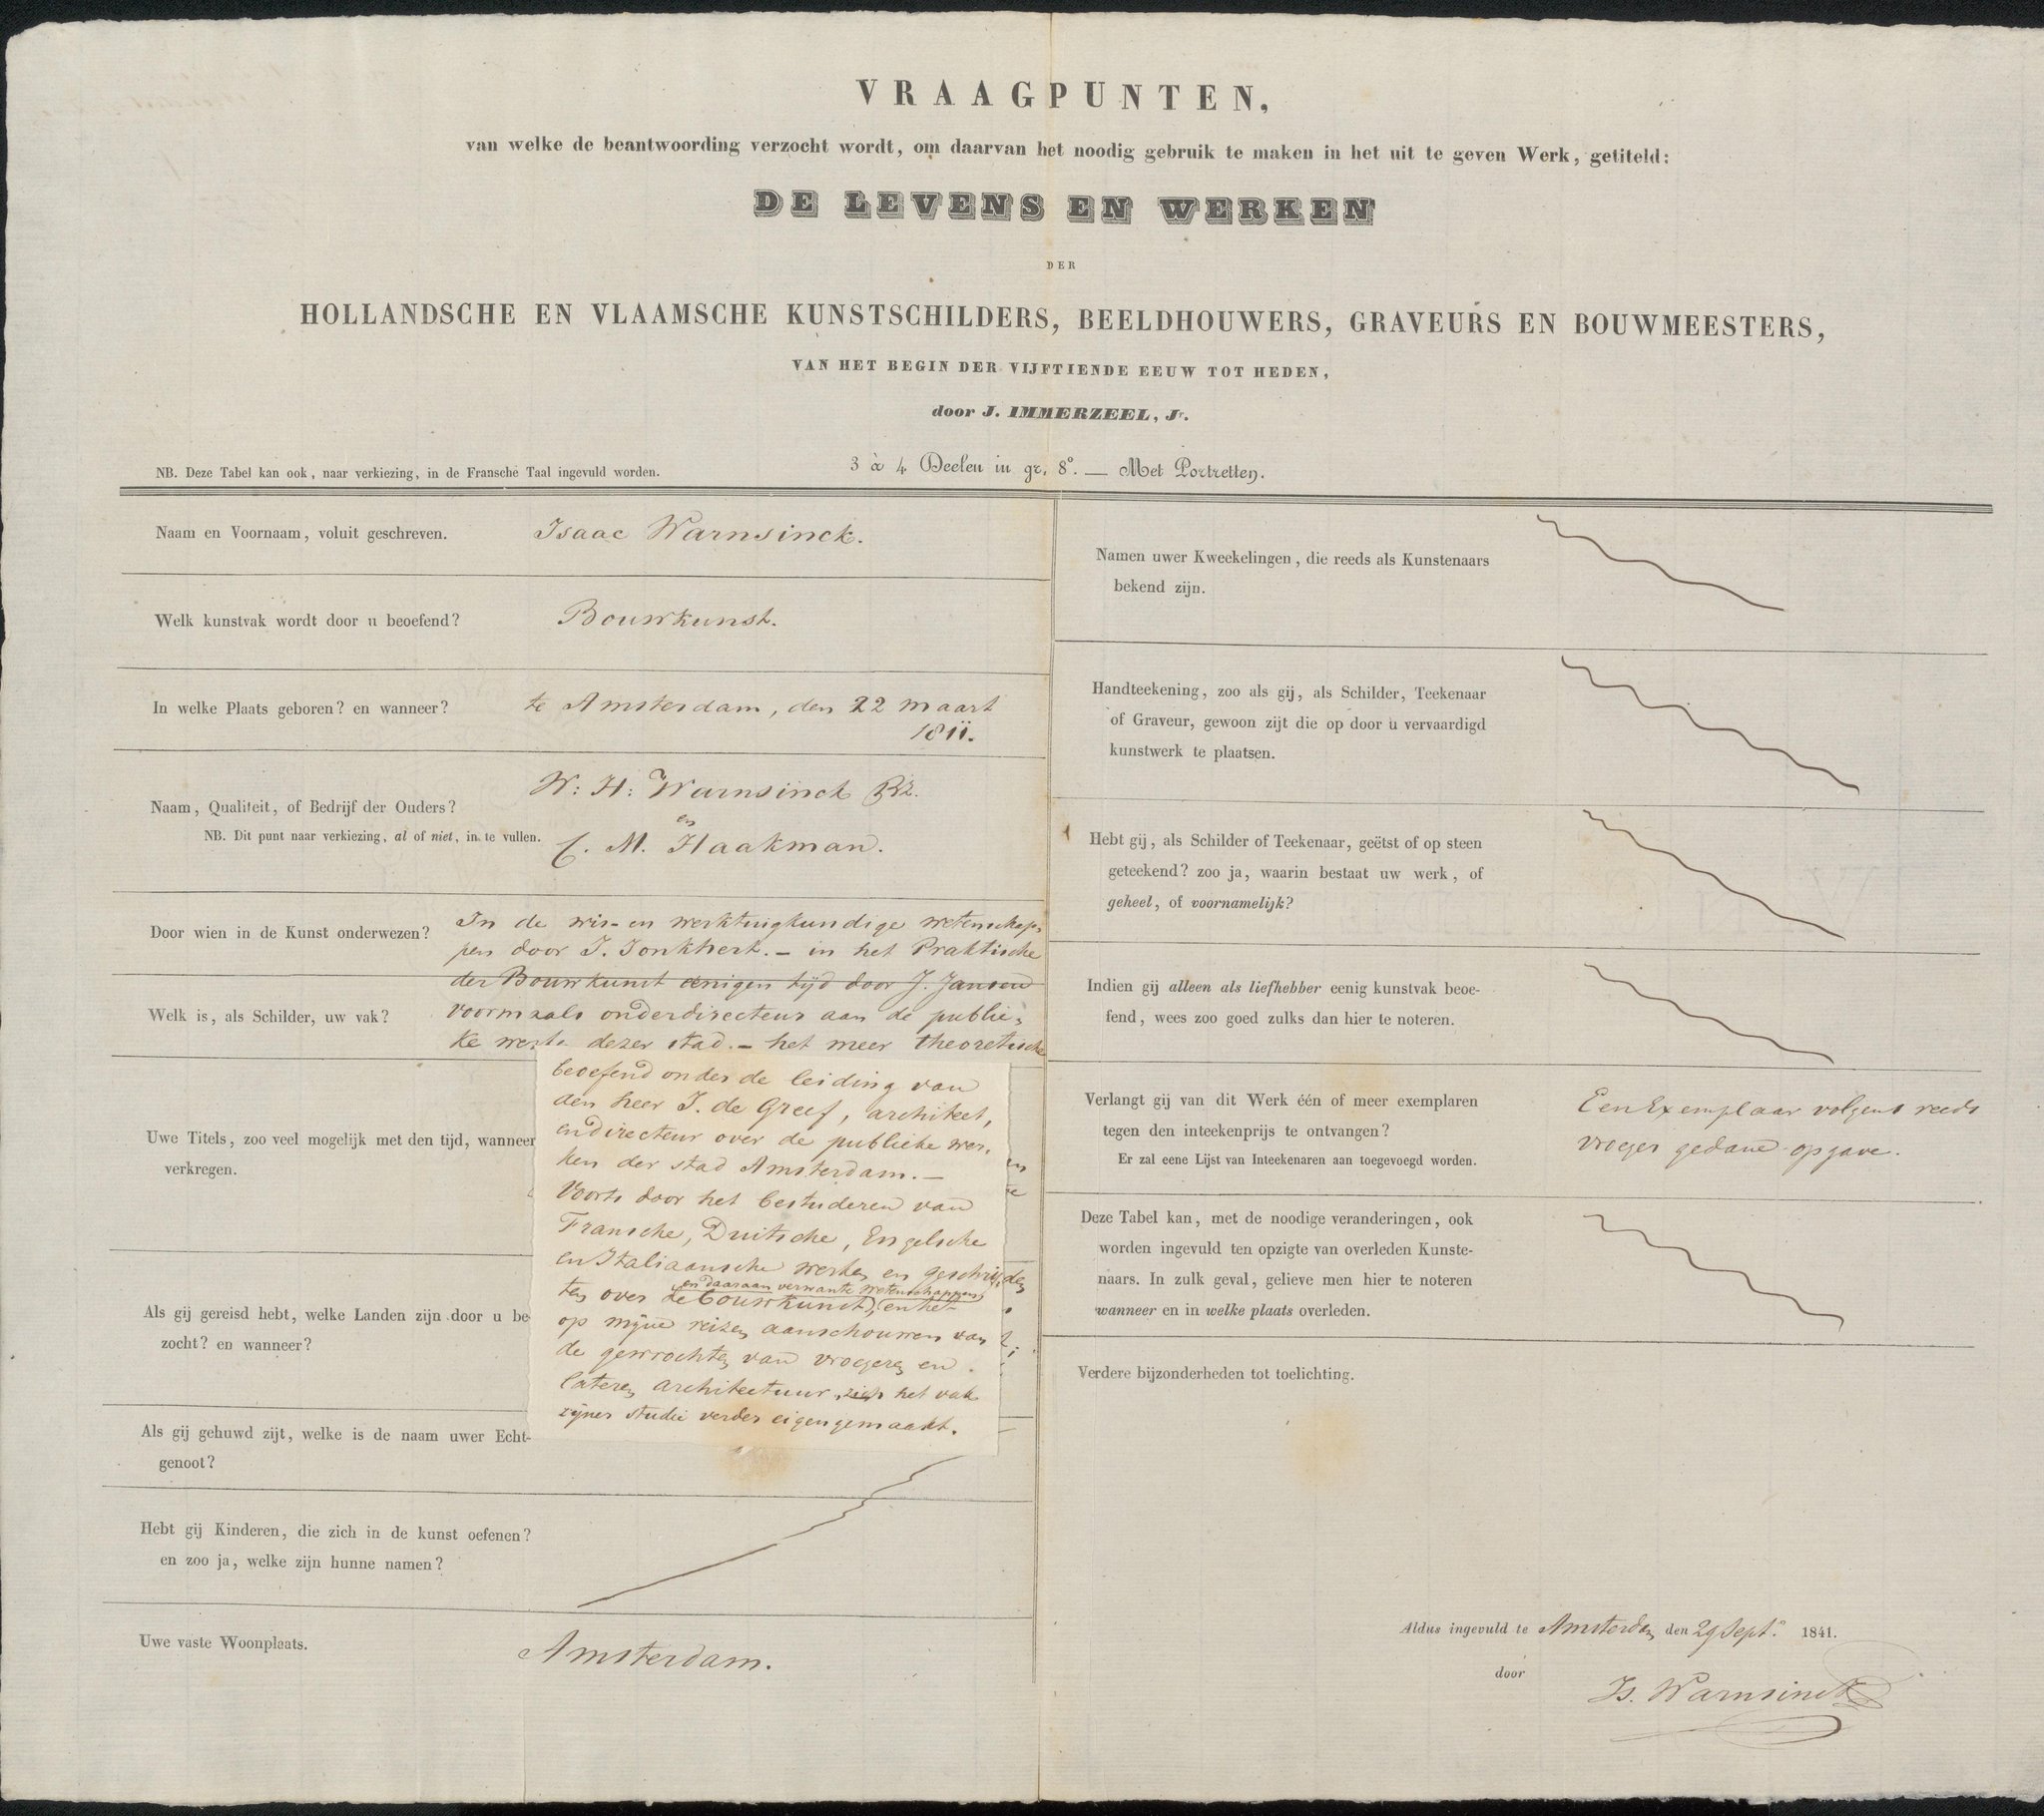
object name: questionnaire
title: Enquêteformulier ingevuld door Isaac Warnsinck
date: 1841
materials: ink, paper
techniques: pen, printing, writing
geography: amsterdam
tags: isaac warnsinck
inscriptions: inscription: ‘Vraagpunten,/ van welke de beantwoording verzocht wordt, om daarvan het noodig gebruik te maken in het uit te geven Werk, getiteld: De levens en werken/ der Hollandsche en Vlaamsche kunstschilders, beeldhouwers,/ graveurs en bouwmeesters, van het begin der vijftiende eeuw tot heden/ door J. Immerzeel, Jr.’, watermark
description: Opgenomen in: Immerzeel, J. Jr., De levens en werken der Hollandsche en Vlaamsche kunstschilders, beeldhouwers, graveurs en bouwmeesters, van het begin der vijftiende eeuw tot heden, Amsterdam: J.C. van Kesteren, 1842-1843.